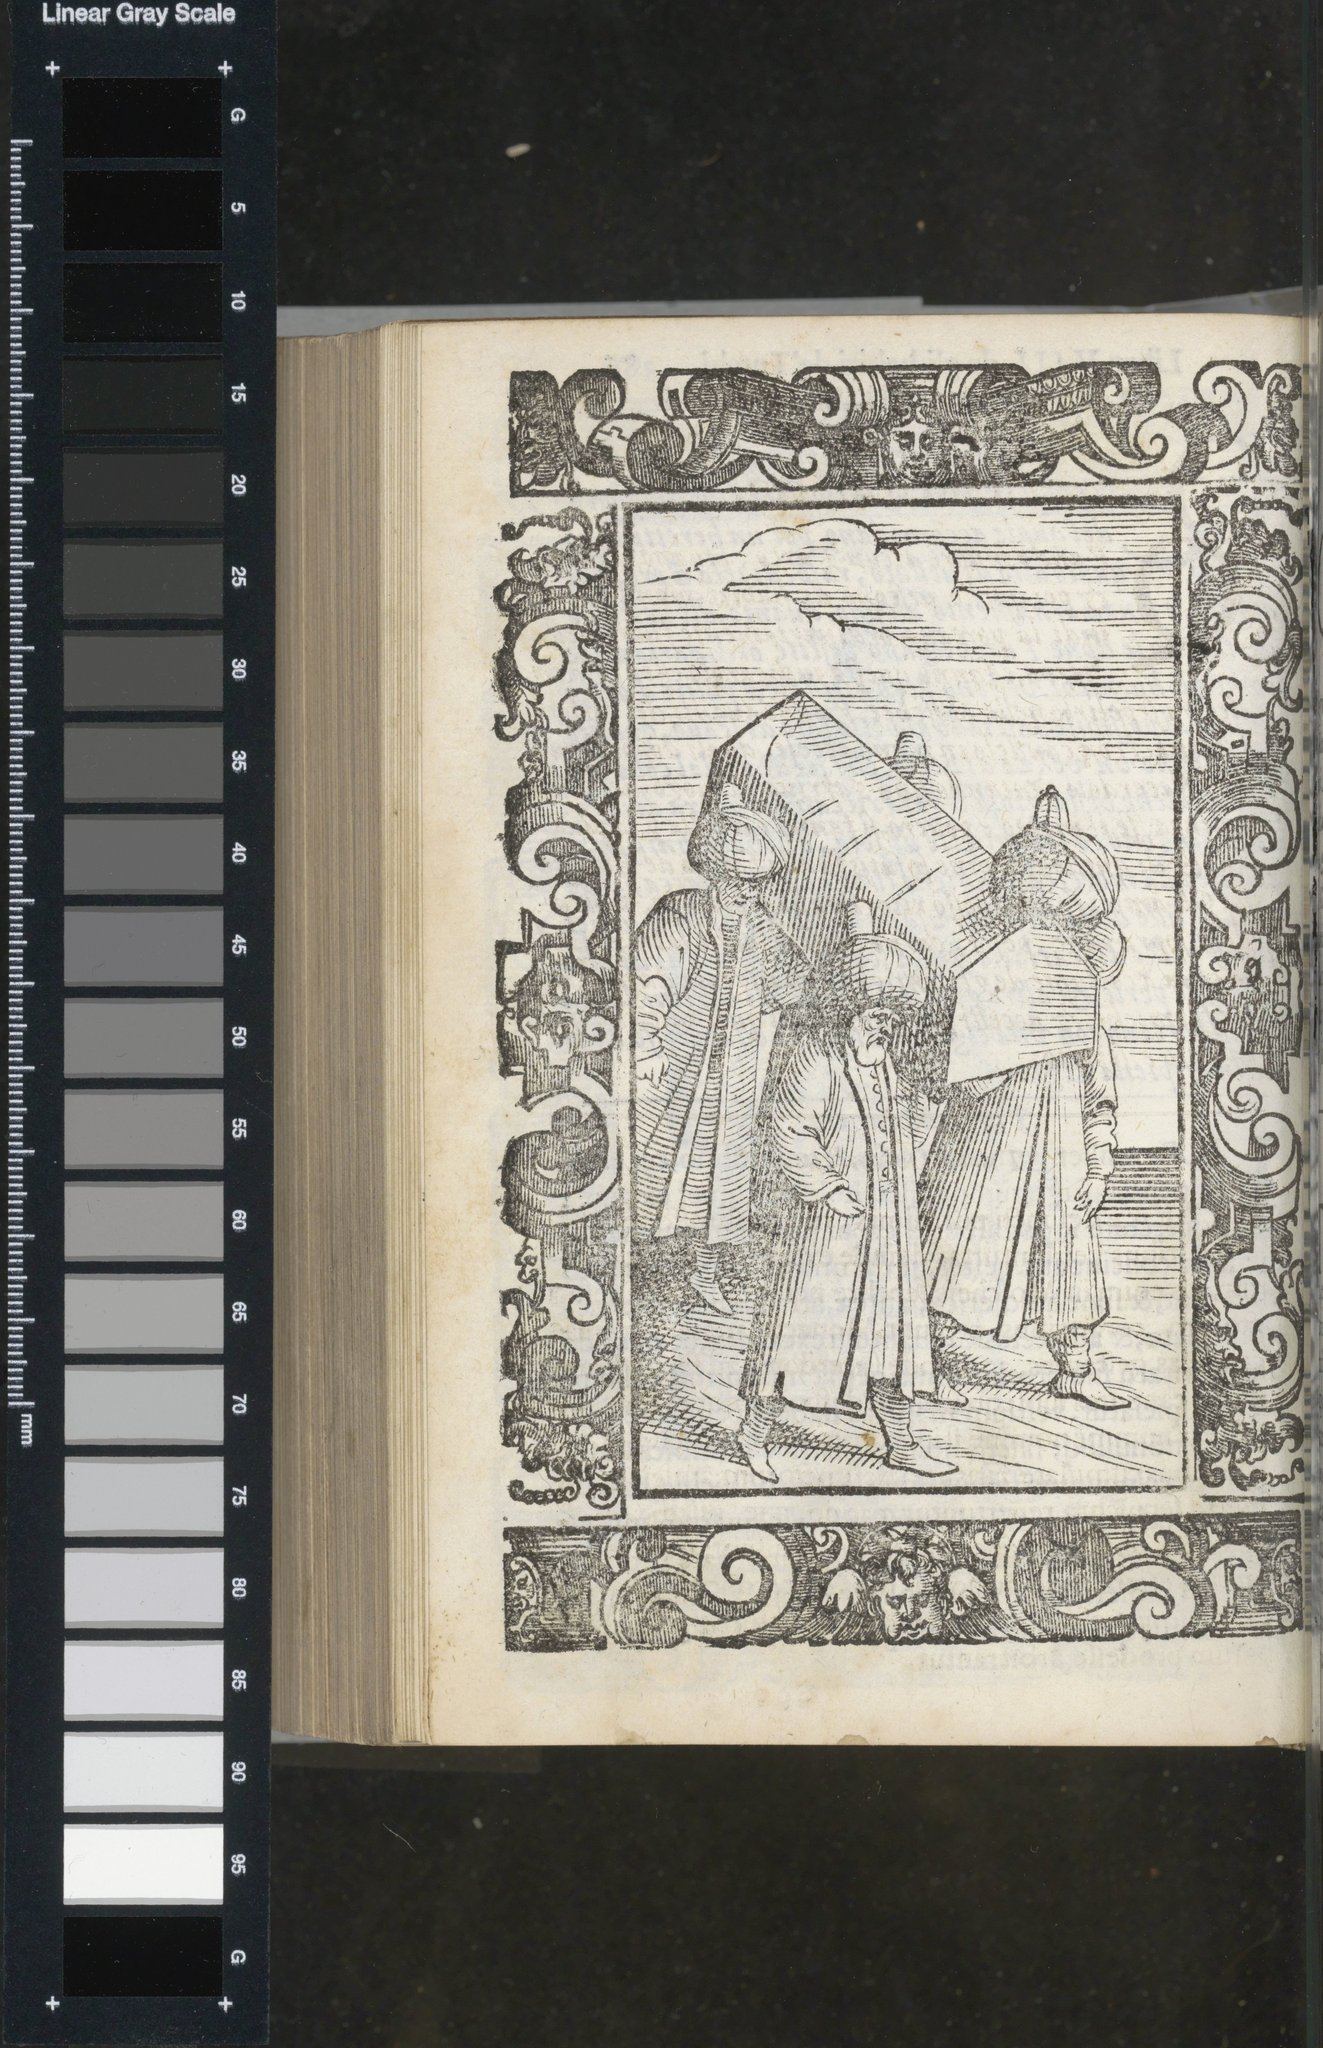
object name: costume print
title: Habiti antichi, et moderni di tutto il mondo...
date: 1598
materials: paper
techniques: woodcut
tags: asiatic races and peoples: turks, cortege, funeral procession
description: De begrafenis van een Turk. De kist wordt gedragen door vier mannen. In ornamentrand